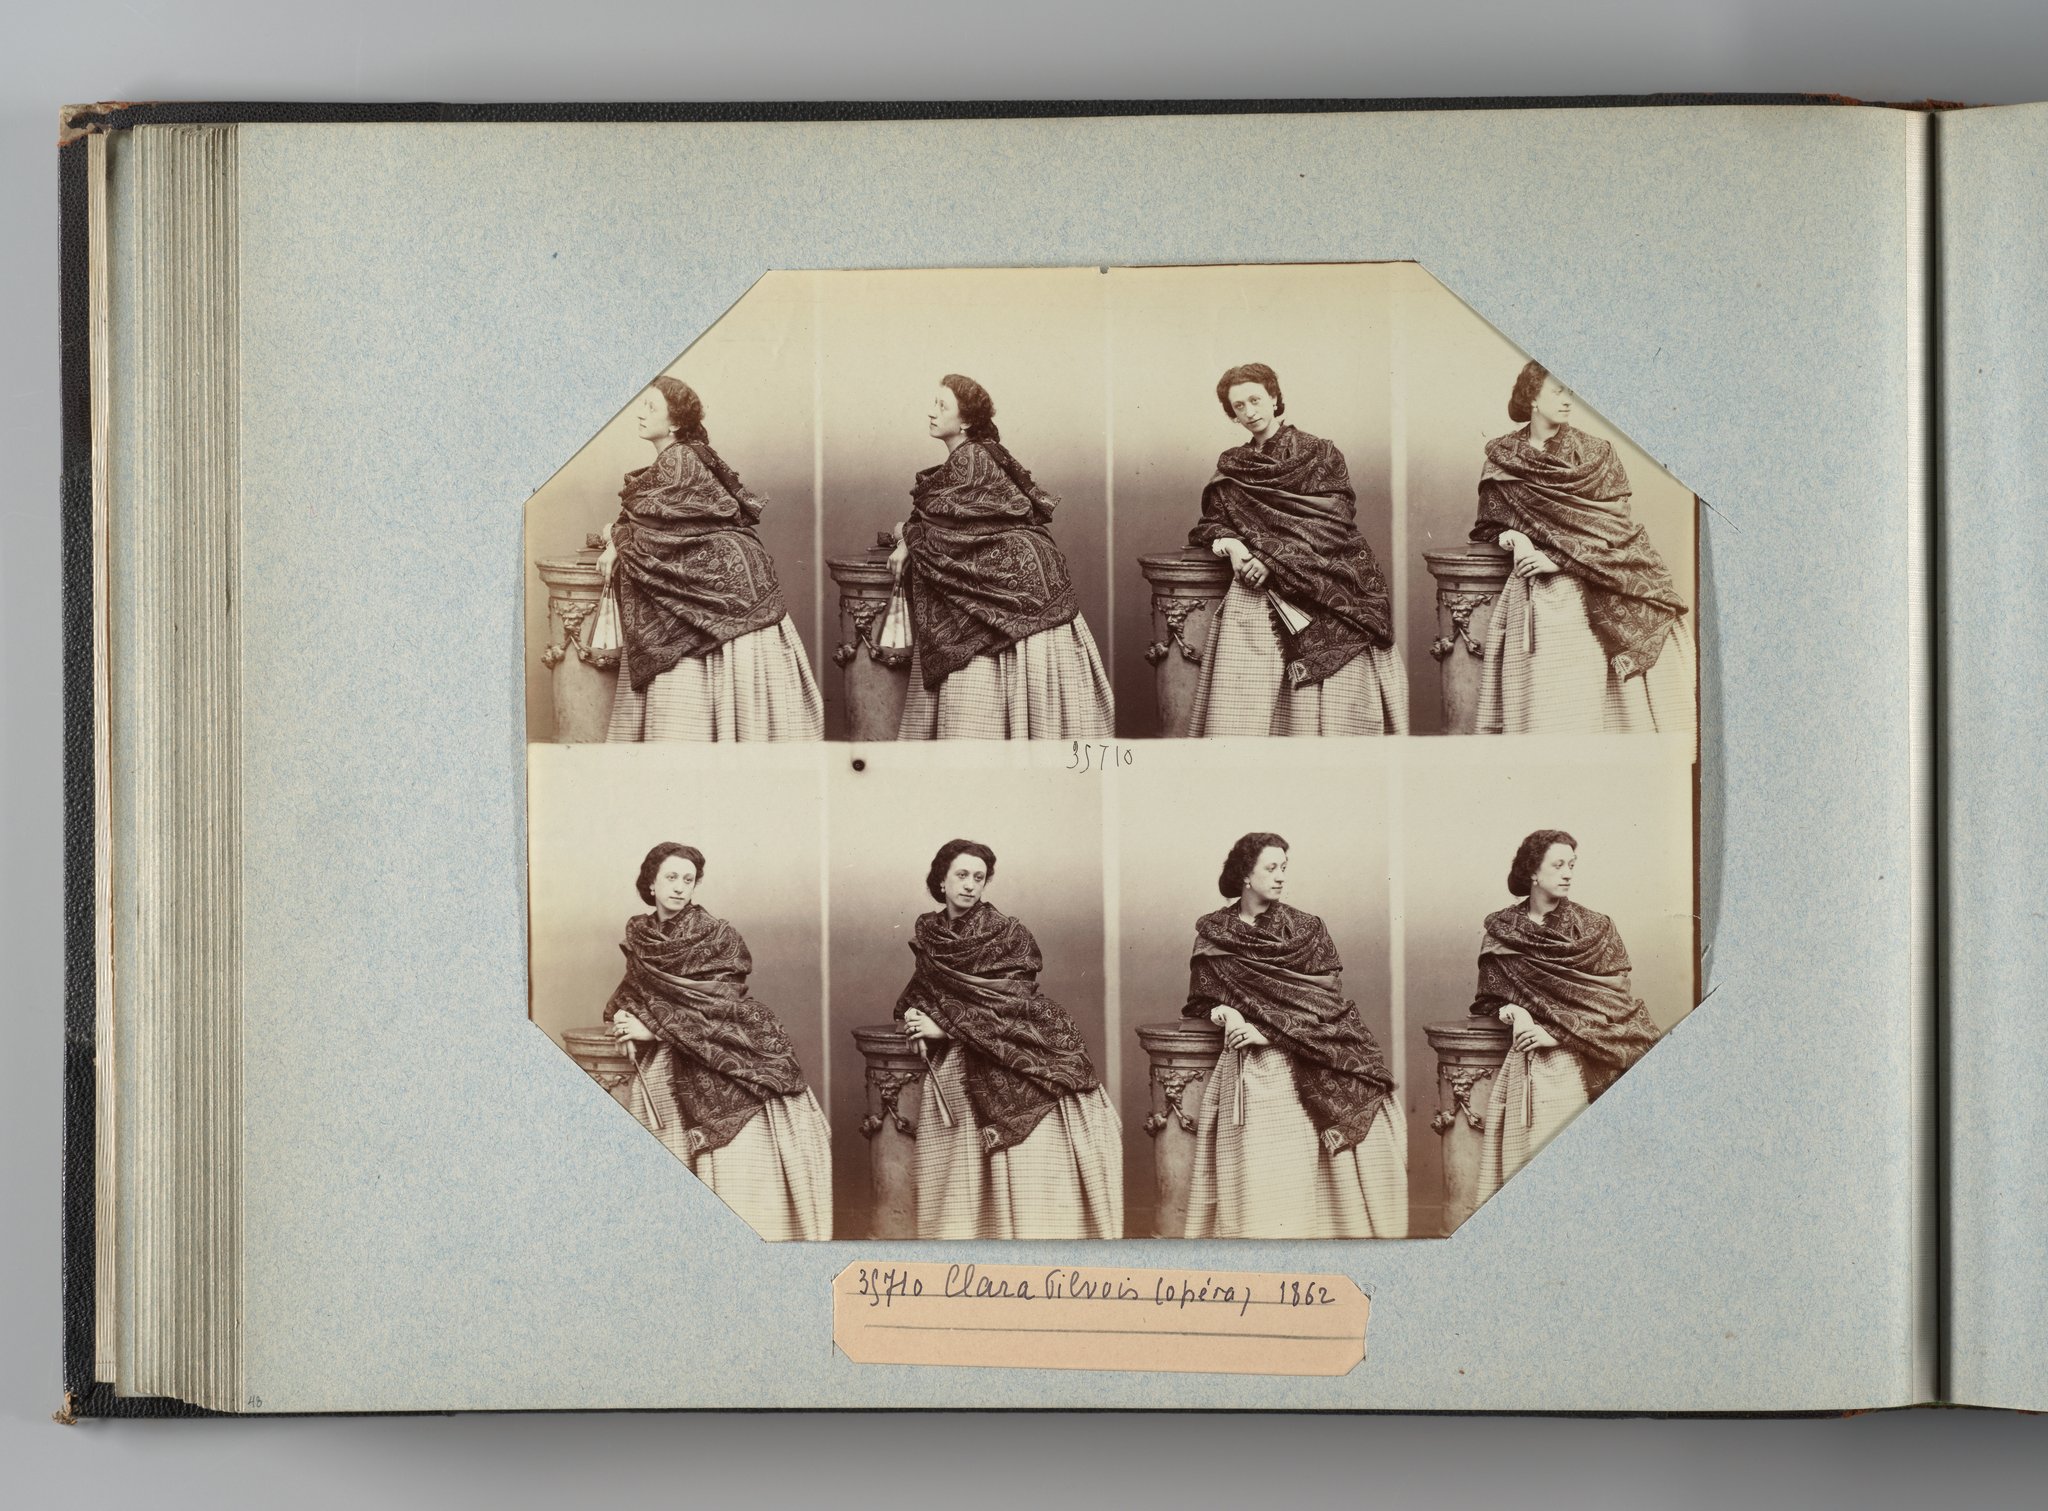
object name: photograph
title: Clara Pilvois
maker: andré-adolphe-eugène disdéri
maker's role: artist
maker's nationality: french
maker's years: 1819-1889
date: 1862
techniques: albumen silver print, glass negative